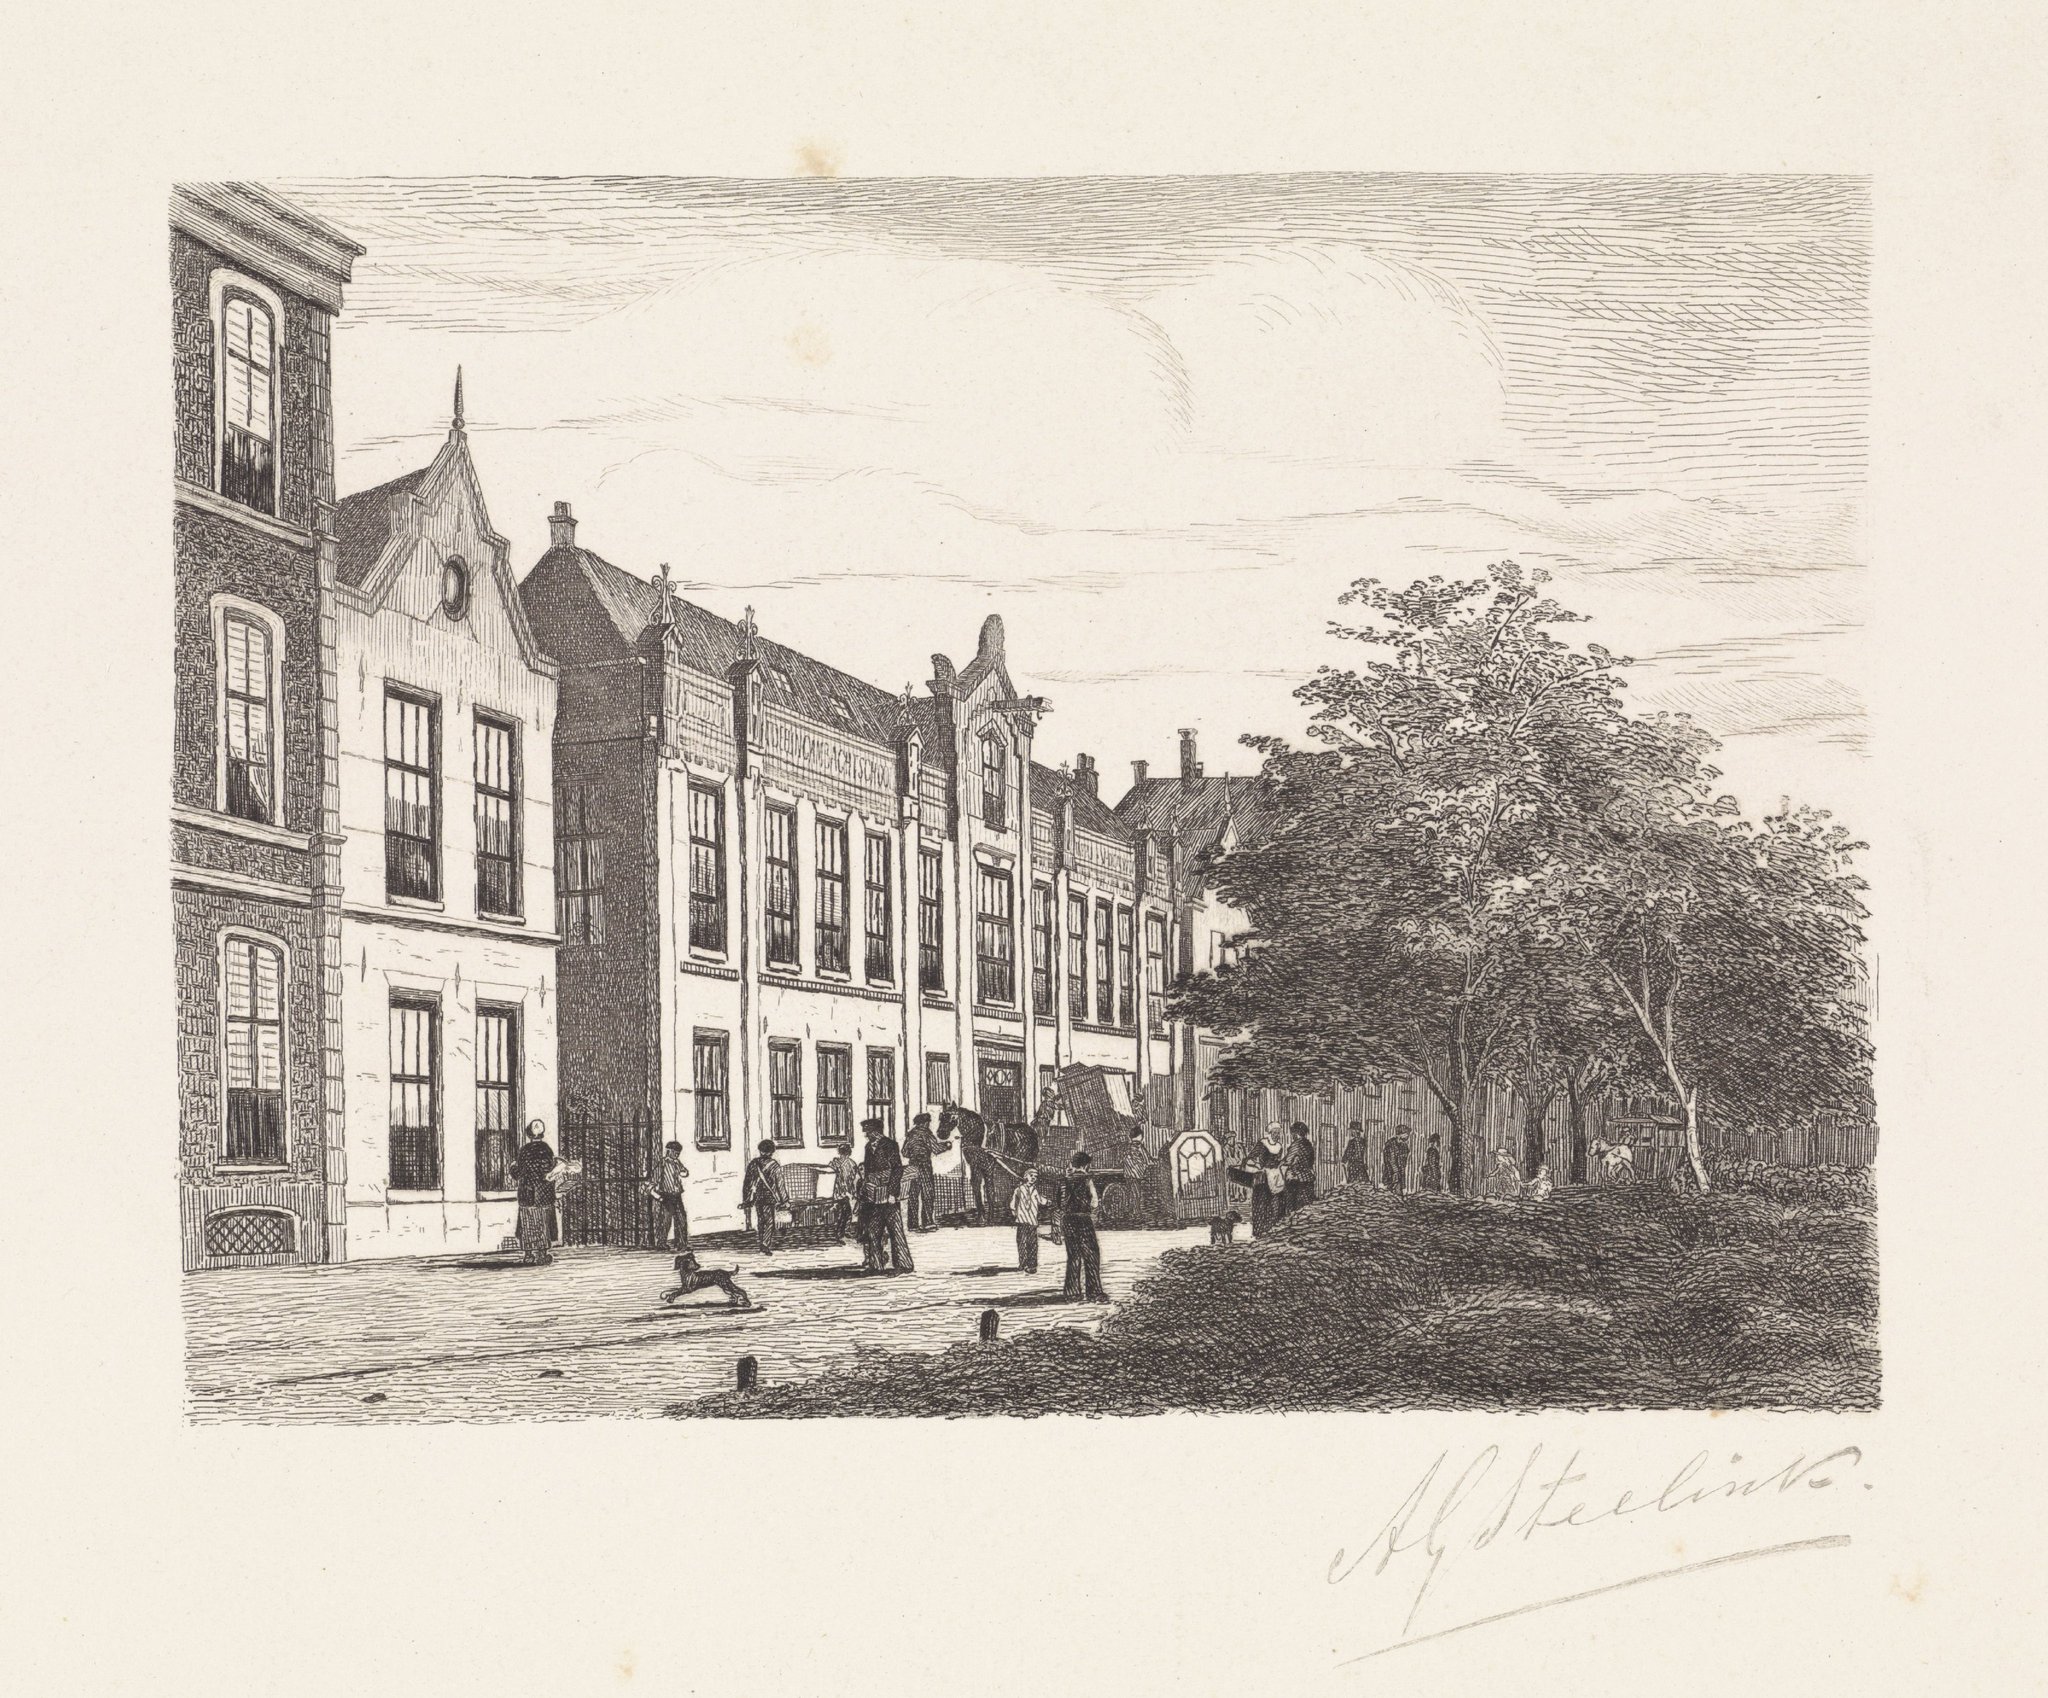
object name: print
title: Straat in een stad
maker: abram george steelink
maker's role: print maker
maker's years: 1844-1920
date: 1857-1920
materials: paper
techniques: etching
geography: amsterdam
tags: traffic and transport, street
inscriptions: collector's mark: Lugt 2228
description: Straatbeeld in een stad. Voor een huis een paardenkar waarop meubels worden geladen.